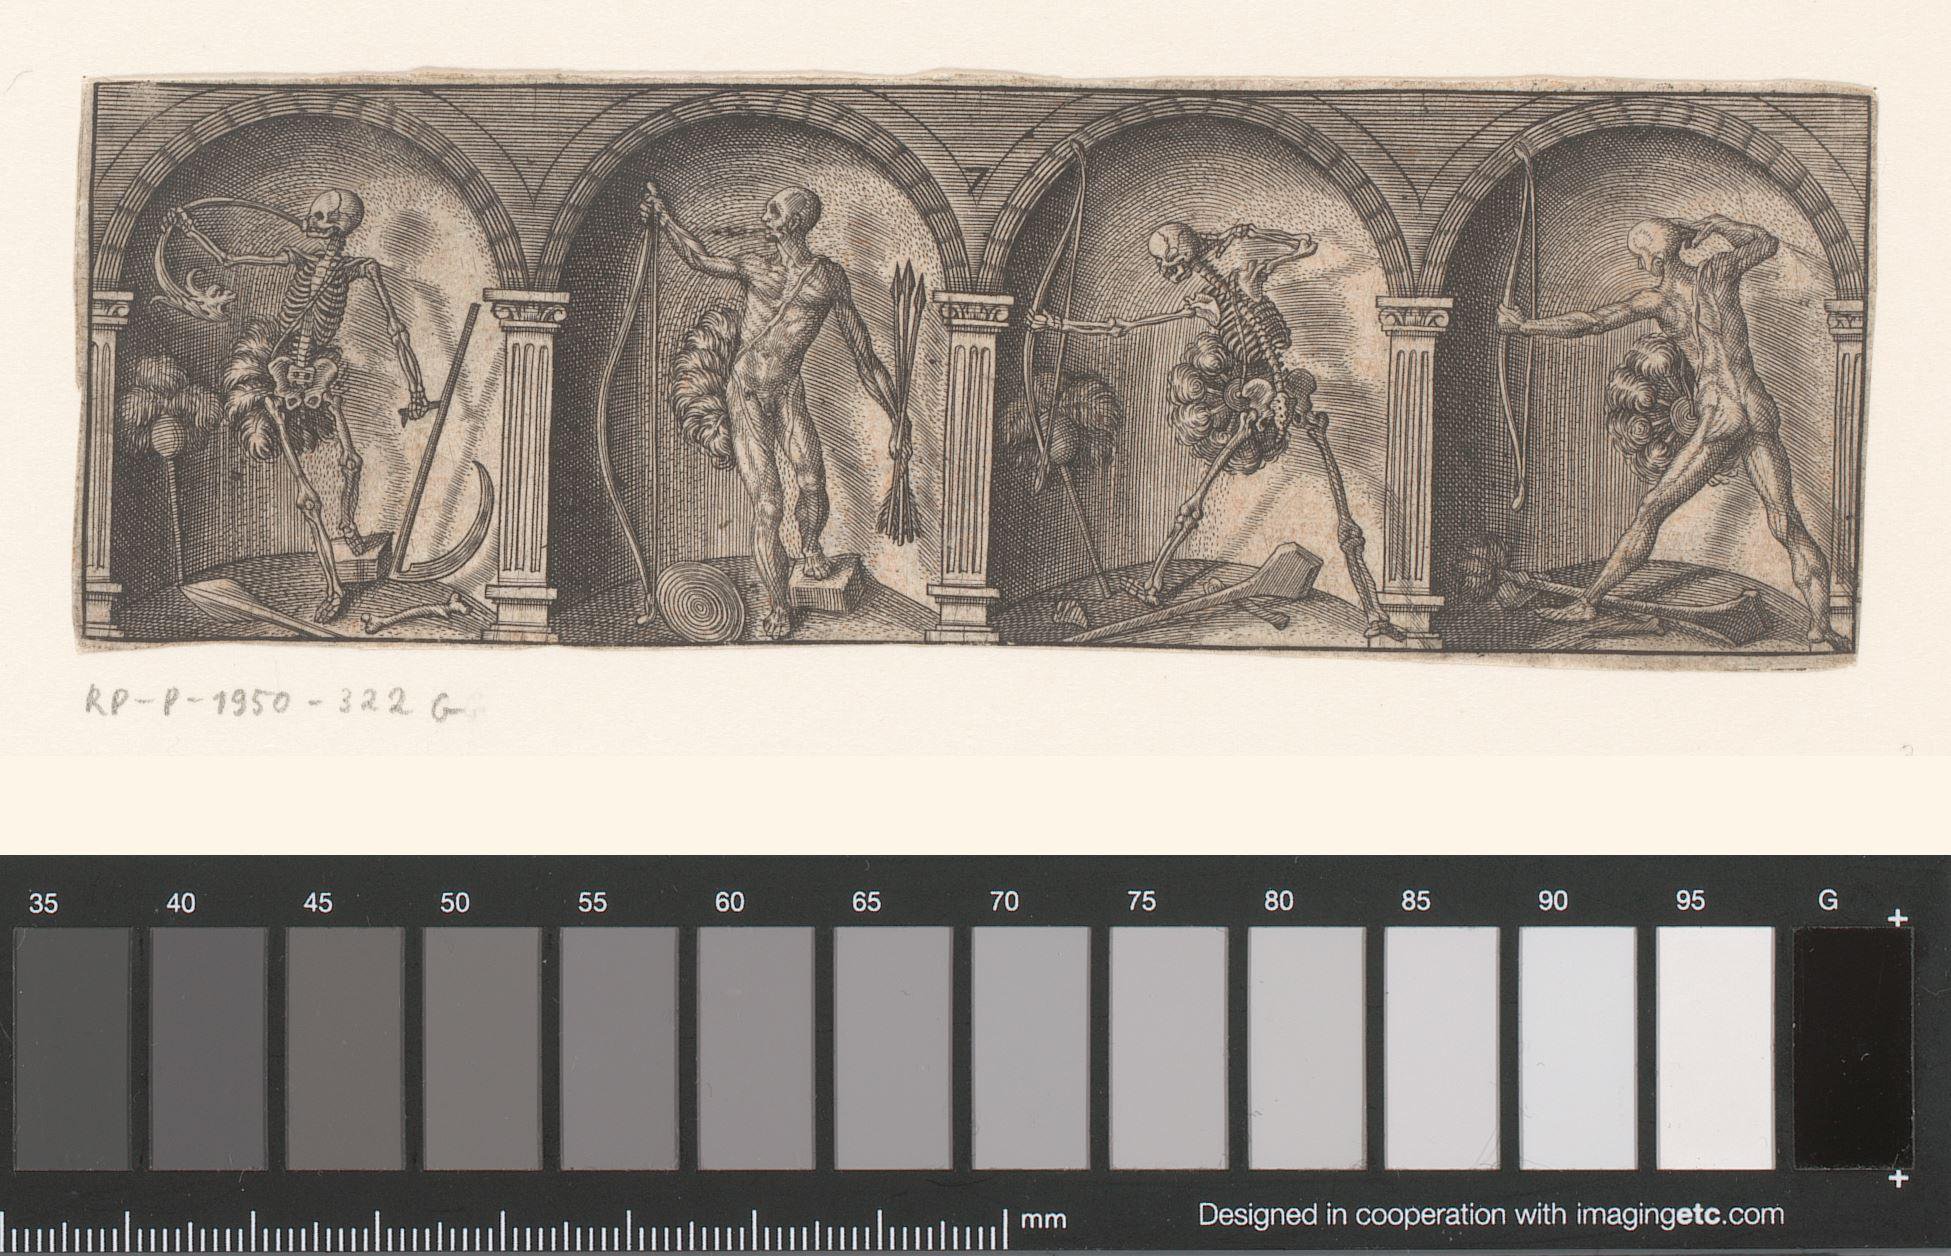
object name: print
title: Les Divers Pourtraicts & figures faictes sus les meurs Des habitans du Nouveau Monde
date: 1610-1640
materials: paper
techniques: engraving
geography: france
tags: parts of church interior: niche, decomposition (of dead body), archer's weapons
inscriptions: collector's mark: Lugt 2228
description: In deze serie worden naakte figuren in vier architecturale niches geplaatst. Zij stellen de inwoners voor van de Nieuwe Wereld.